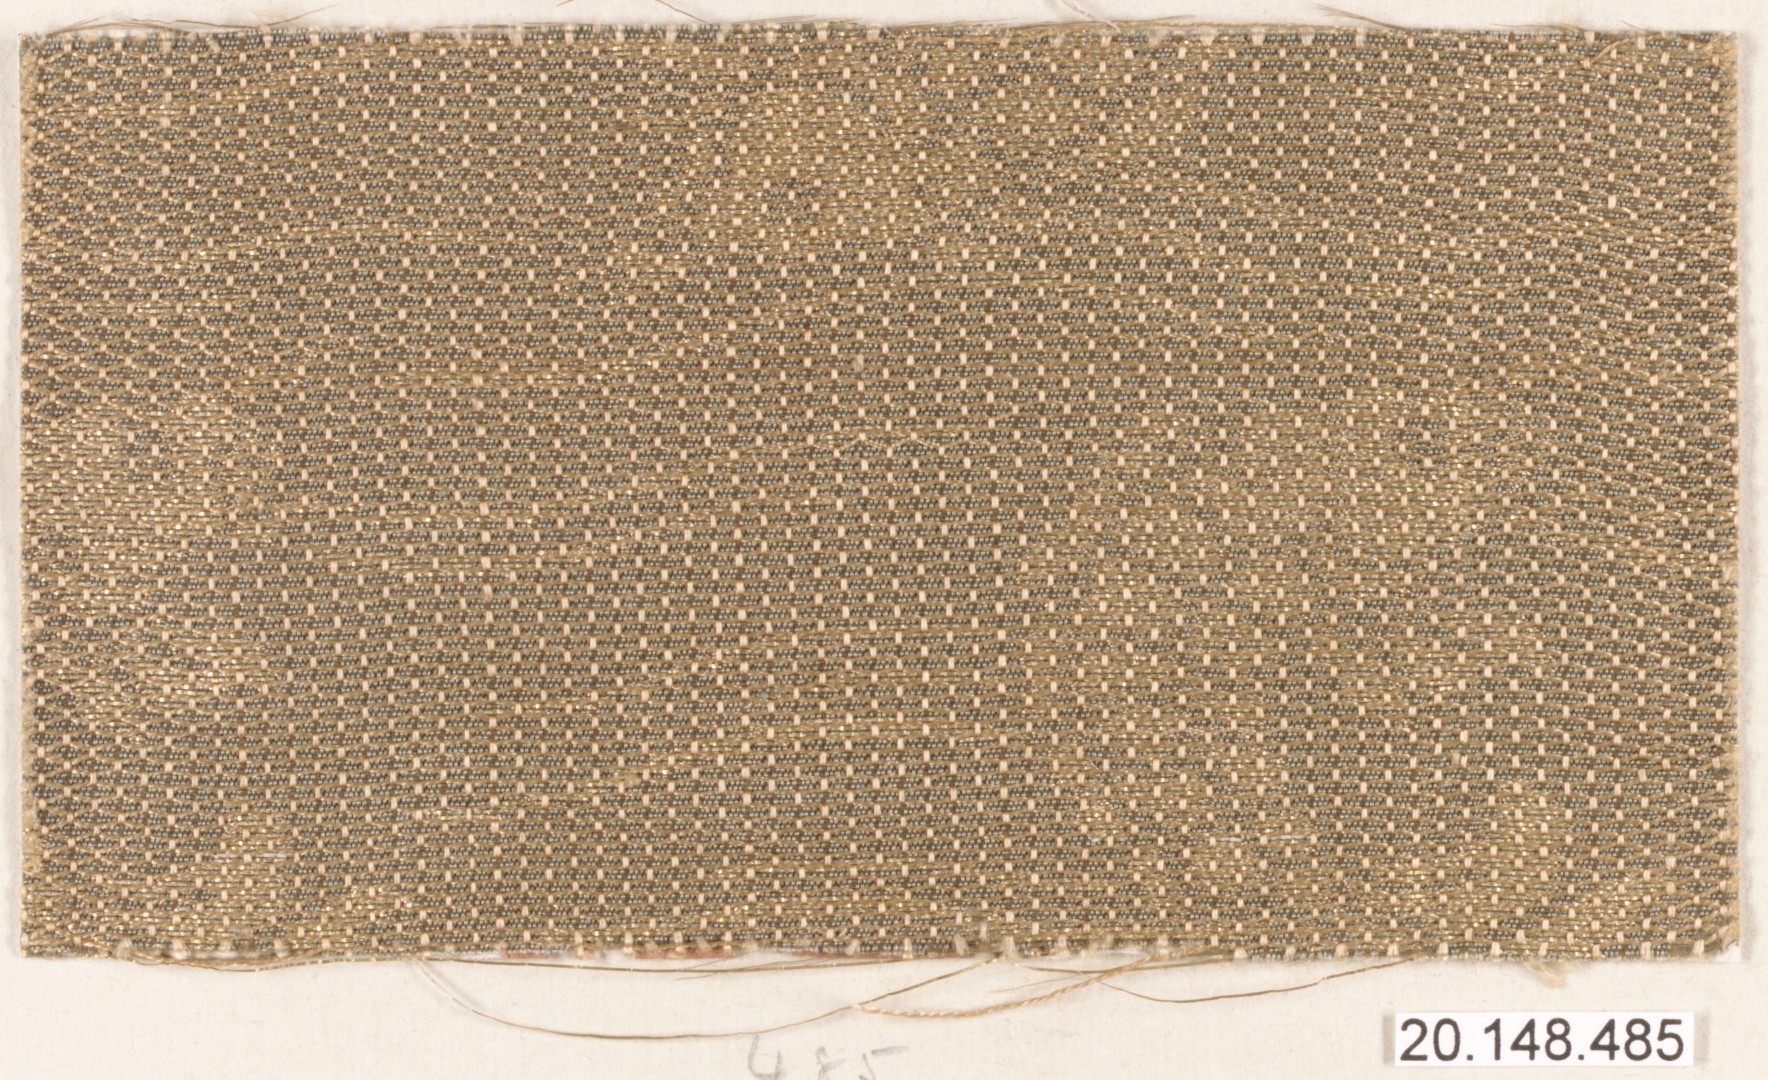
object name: piece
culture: japanese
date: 1701-1800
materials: silk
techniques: compound weave